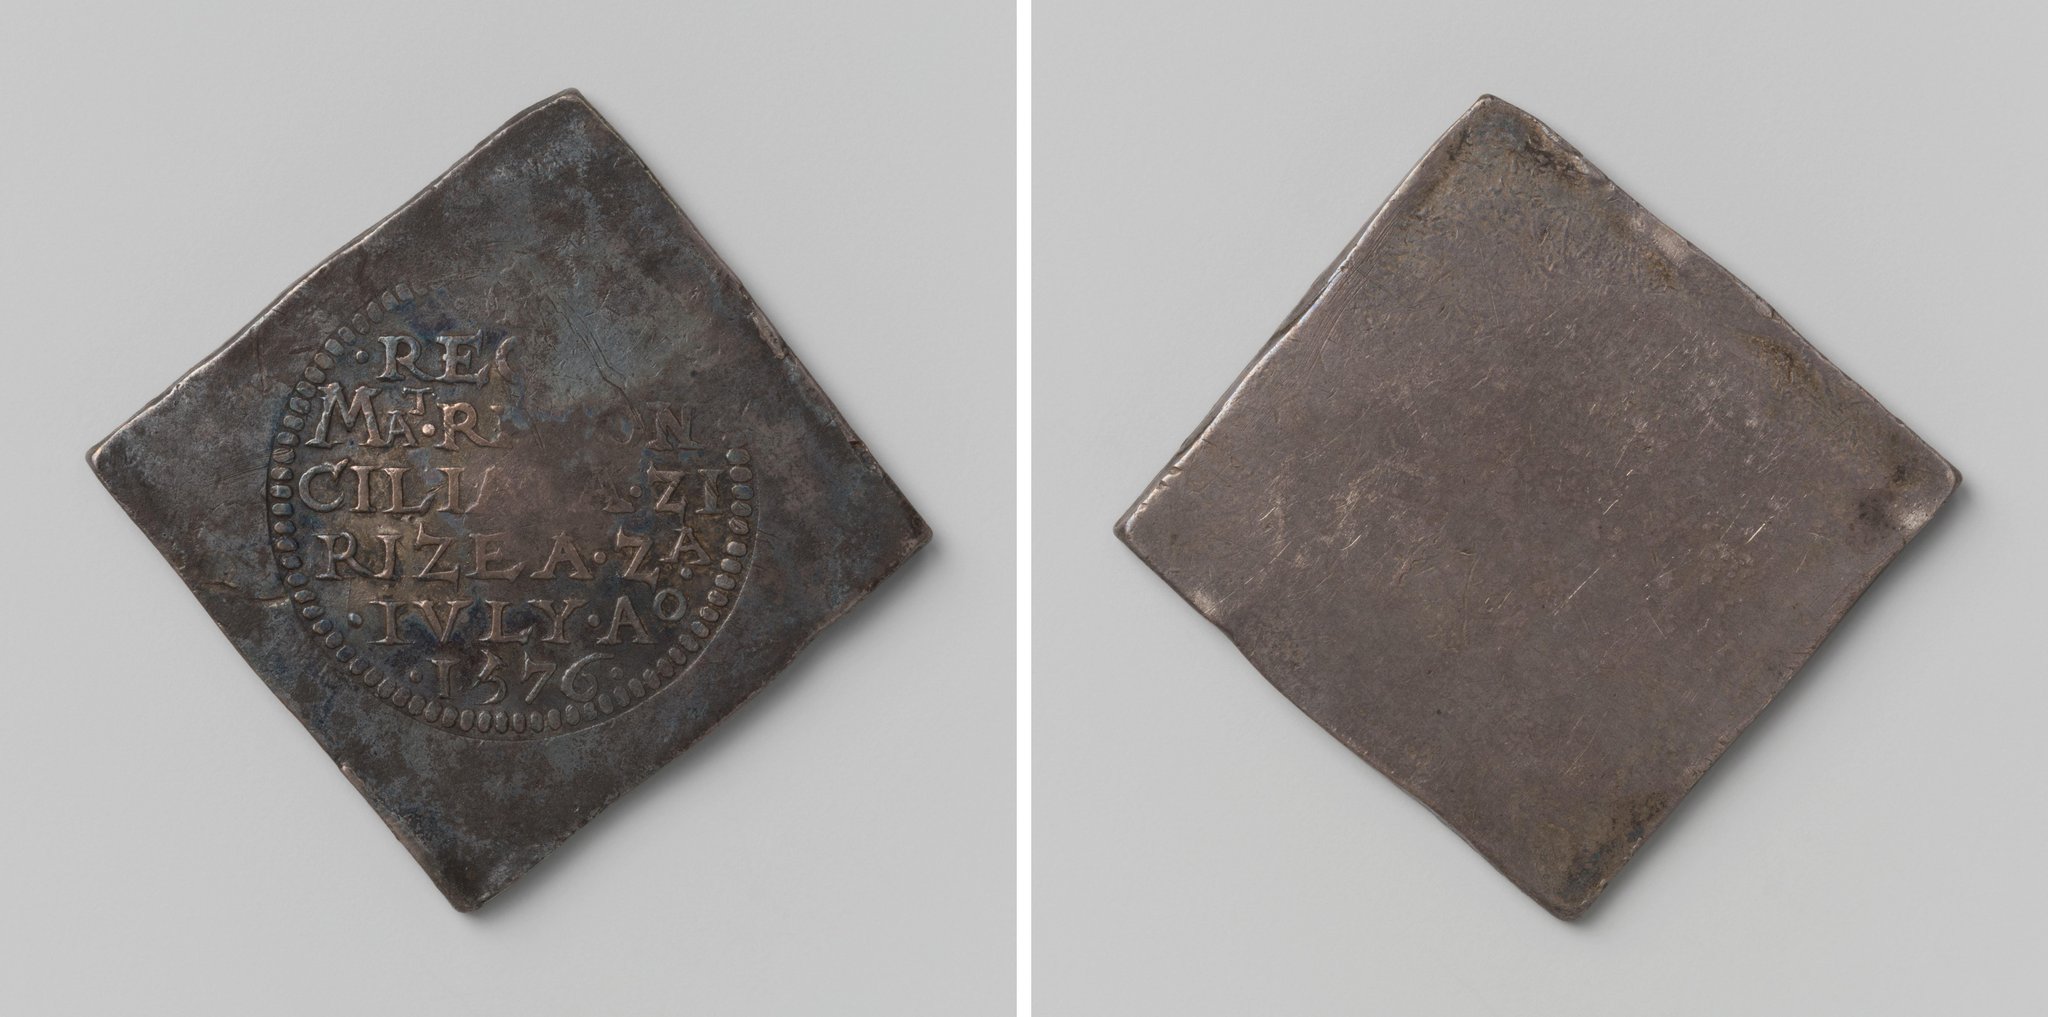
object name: coin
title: Halve daalder, noodmunt uit Zierikzee, geslagen na de verovering van de stad van het opgebrachte zilver om plundering te voorkomen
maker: Anonymous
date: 1576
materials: silver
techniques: striking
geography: netherlands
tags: zierikzee, tachtigjarige oorlog, beleg van zierikzee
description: eenzijdige, ruitvormige noodmunt. Voorzijde: opschrift binnen ronde parelrand. Keerzijde: blanco